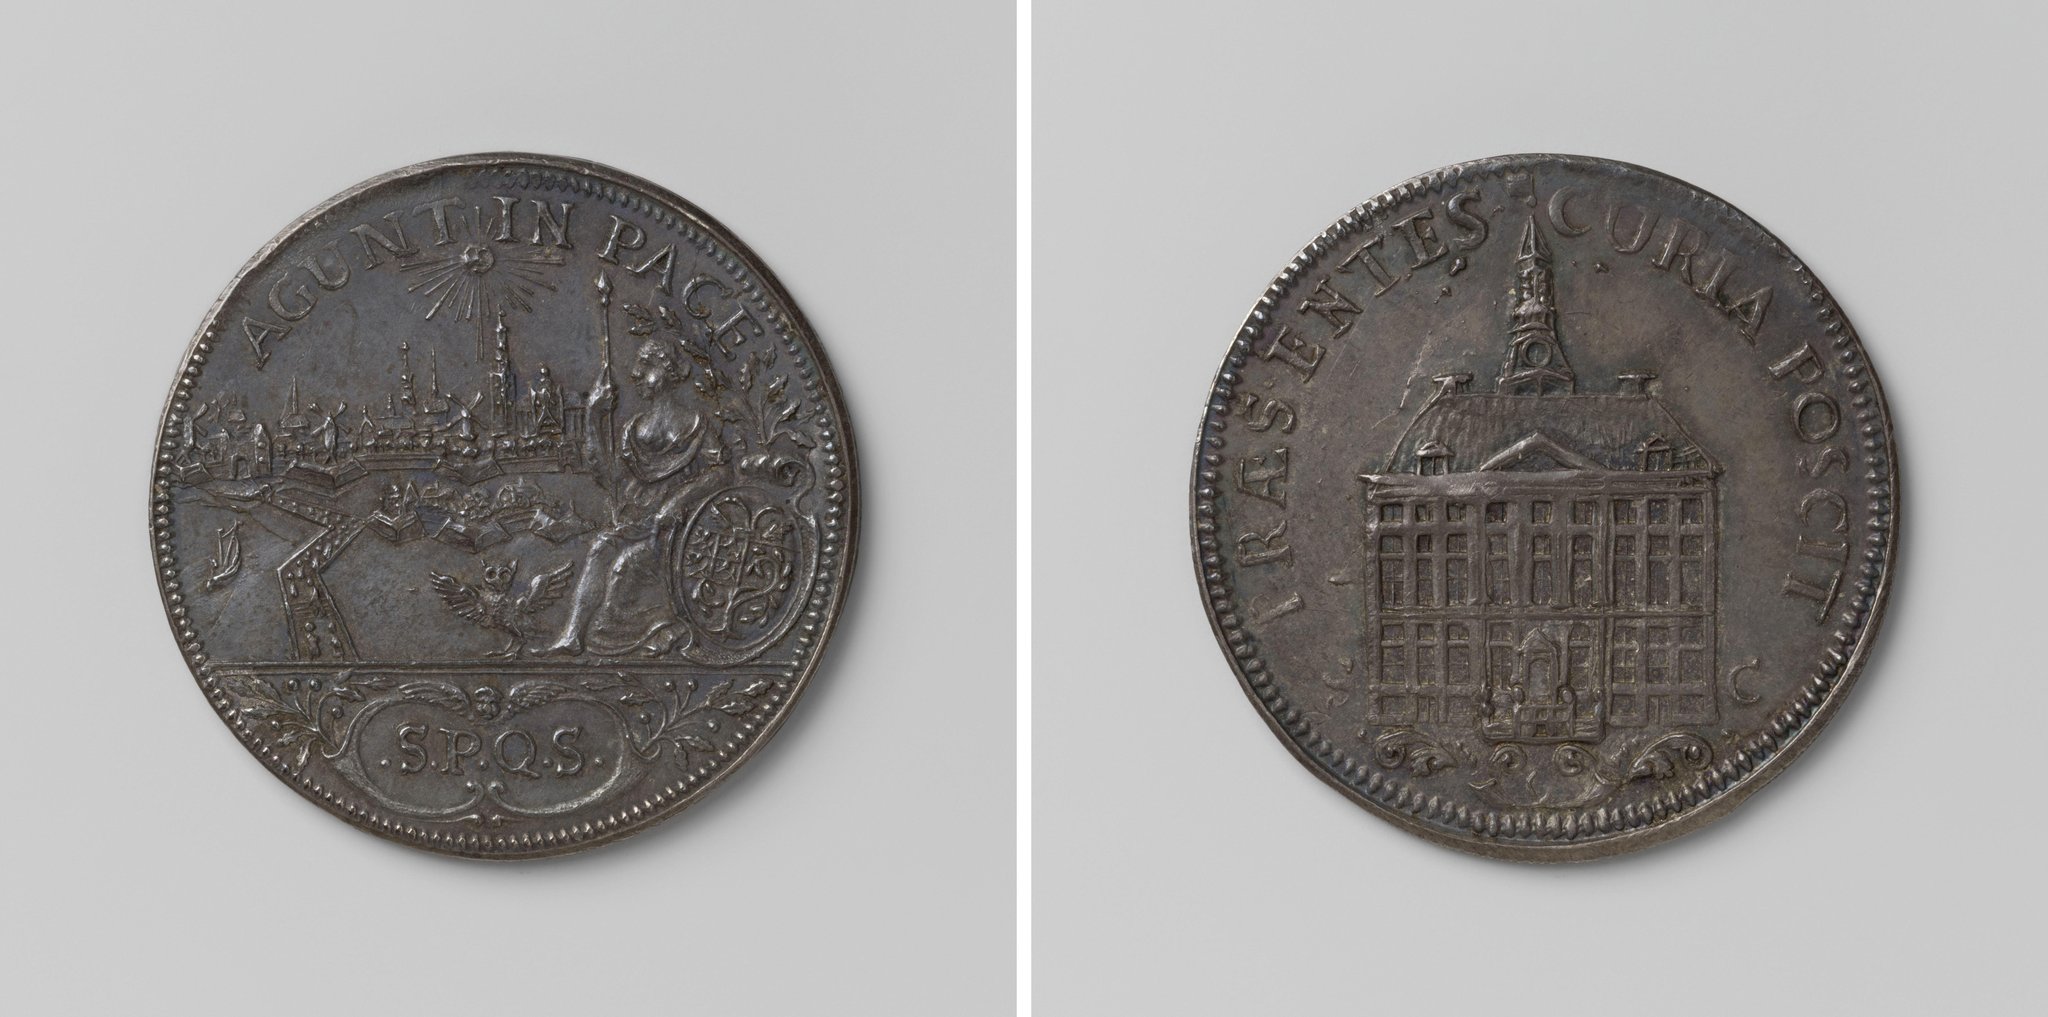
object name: council medal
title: Vroedschapspenning van de stad 's-Hertogenbosch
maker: theodorus casparus van berckel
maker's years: 1680-1734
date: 1714-1720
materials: silver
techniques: striking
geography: den bosch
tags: den bosch